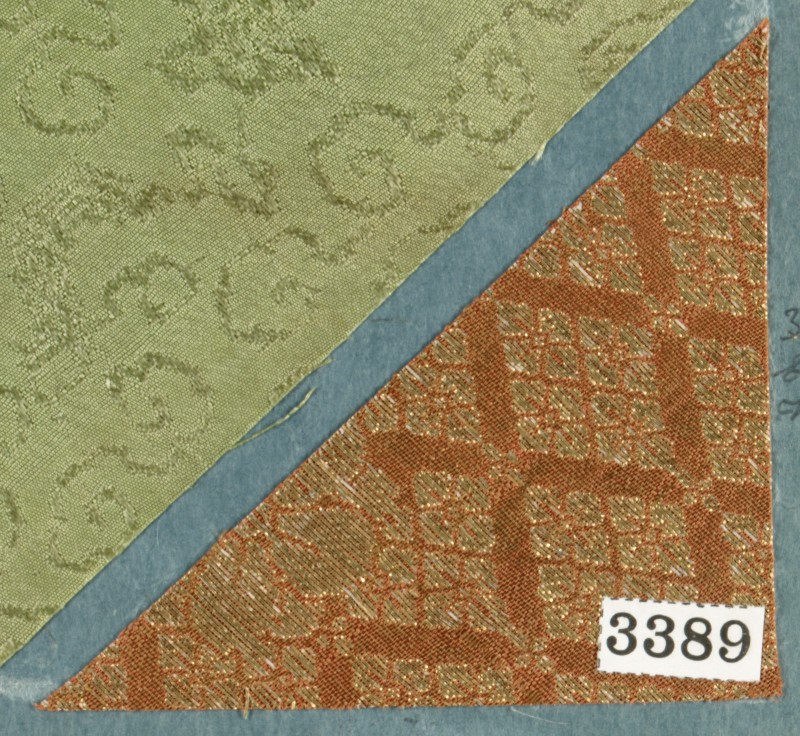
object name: textile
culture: japanese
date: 1801-1900